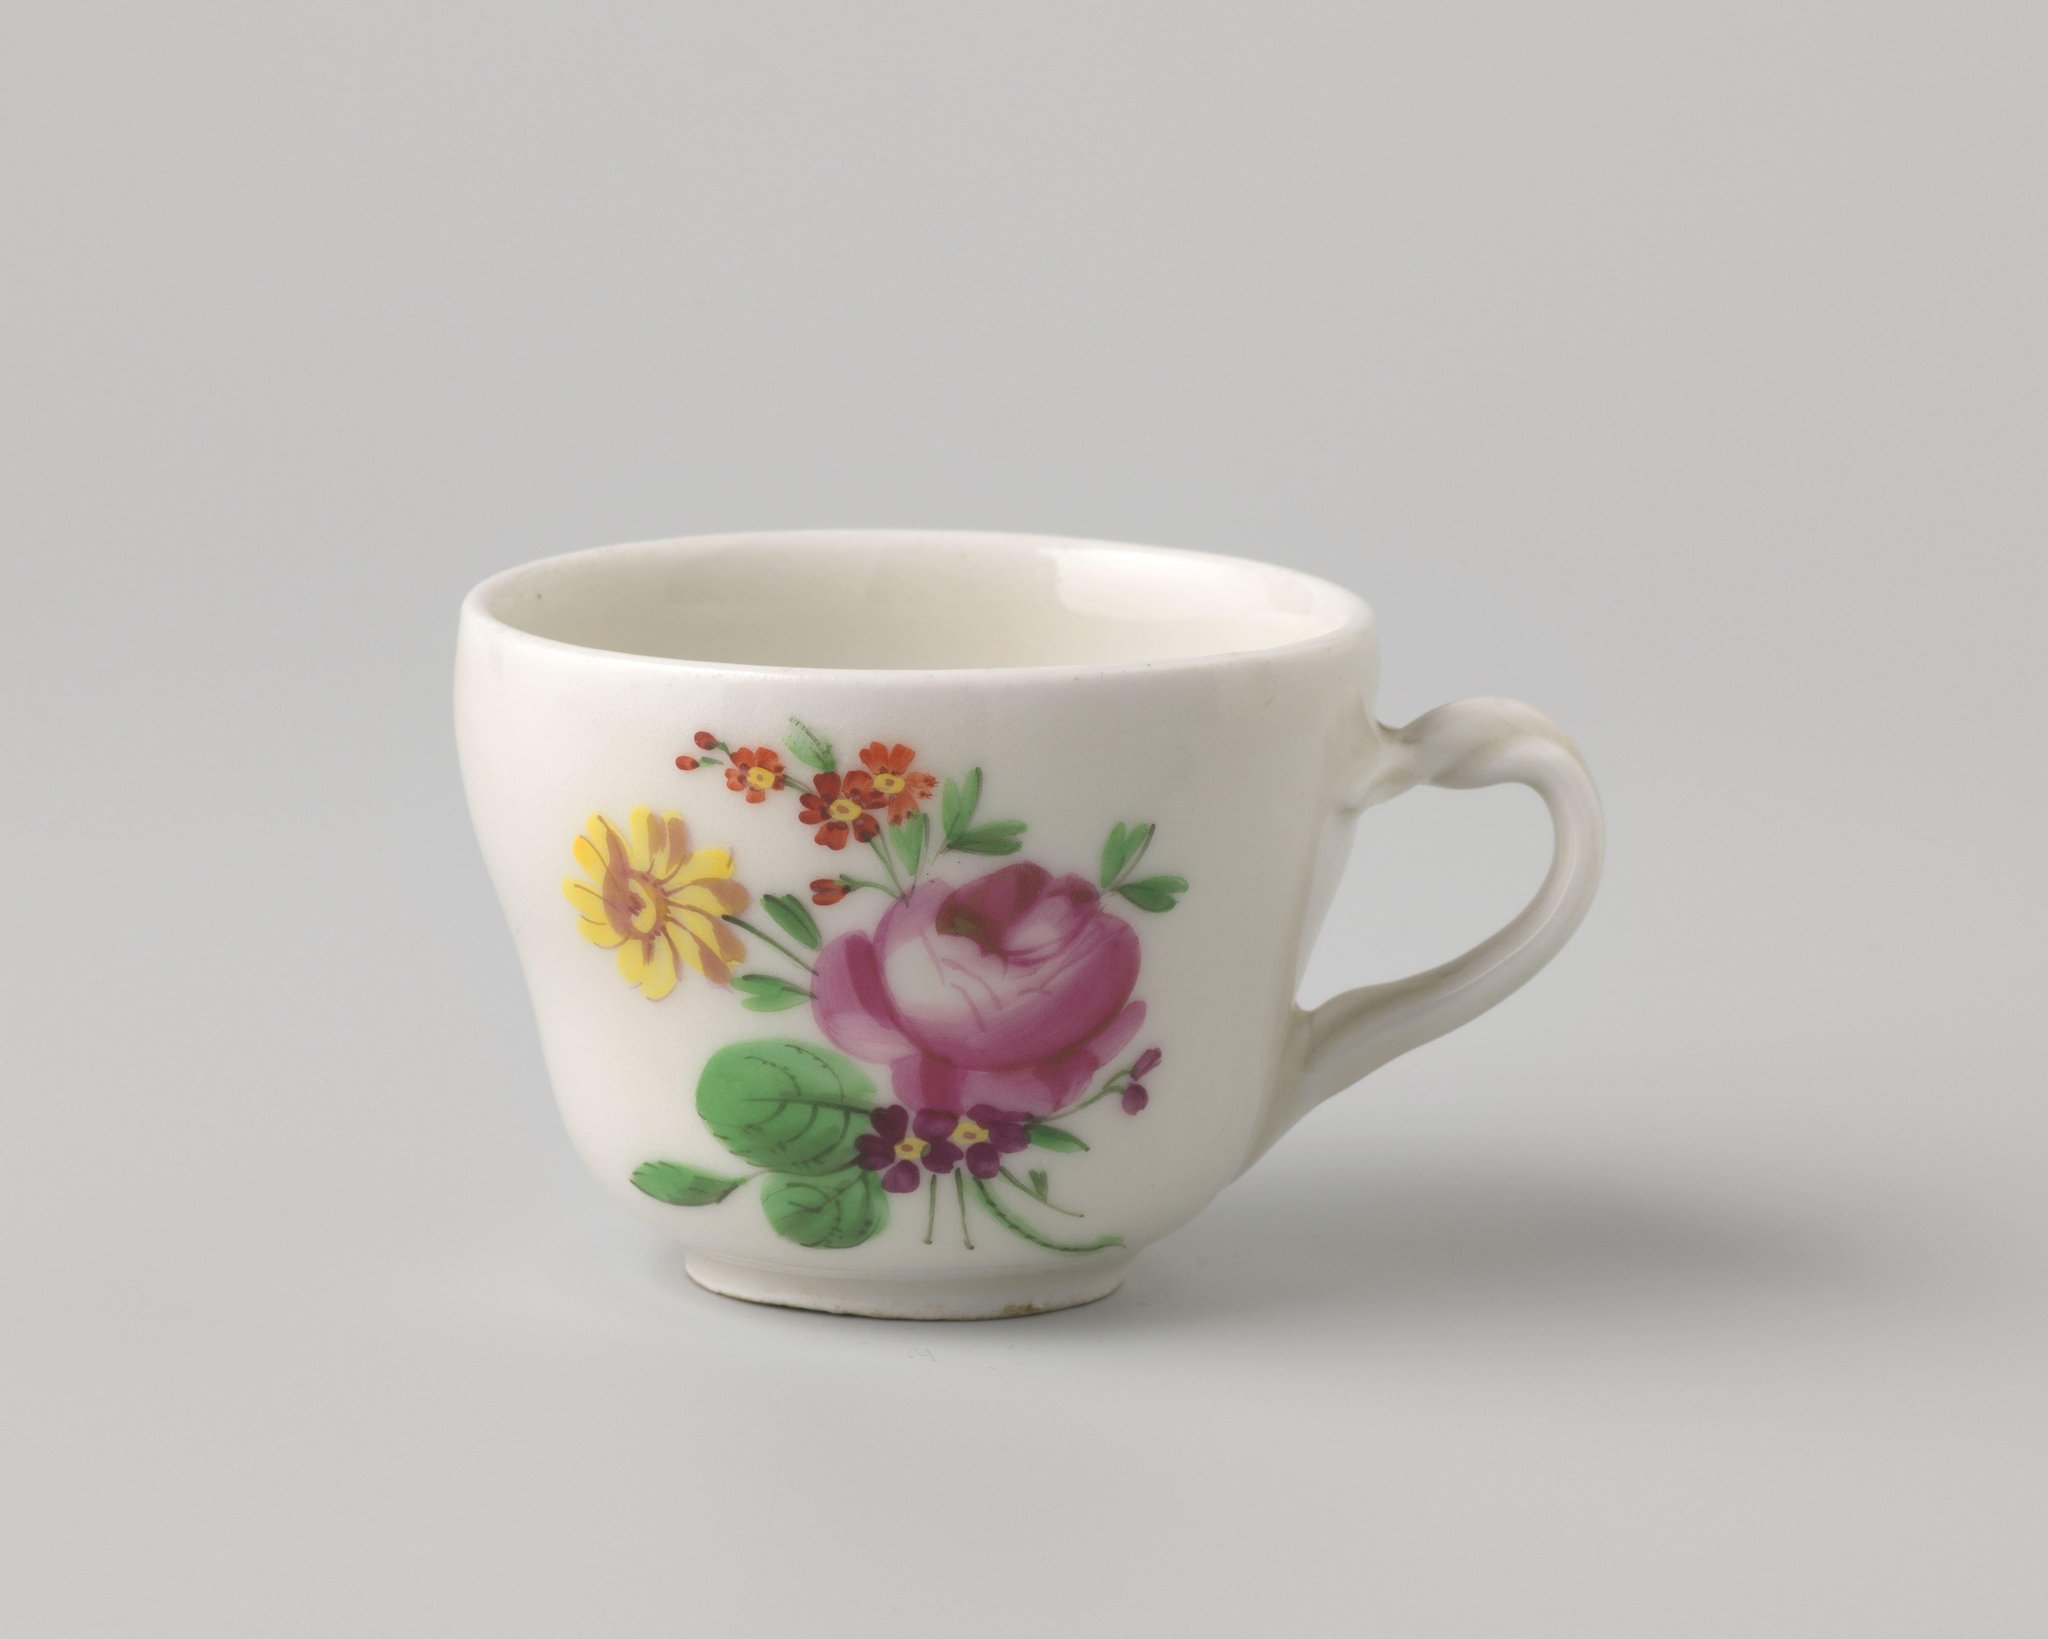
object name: cup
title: Cup with a bouquet and flower sprays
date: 1831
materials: glaze, paint, porcelain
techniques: firing, forming, turning, vitrification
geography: vienna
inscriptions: mark: ‘schild/ D/ 8/ 831’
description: Kop, onderdeel van een servies beschilderd met veelkleurige bloemboeketten en strooibloemen. Aan het kopje een oor in de vorm van twee verstrengelde takken. Merken niet voor alle koppen gelijk (bk-1956-63-24/33): o.a. in paars de getallen 83 en 43 en ingegrift de getallen 39 en 800; in onderglazuur blauw een schild met twee dwarsbalken.